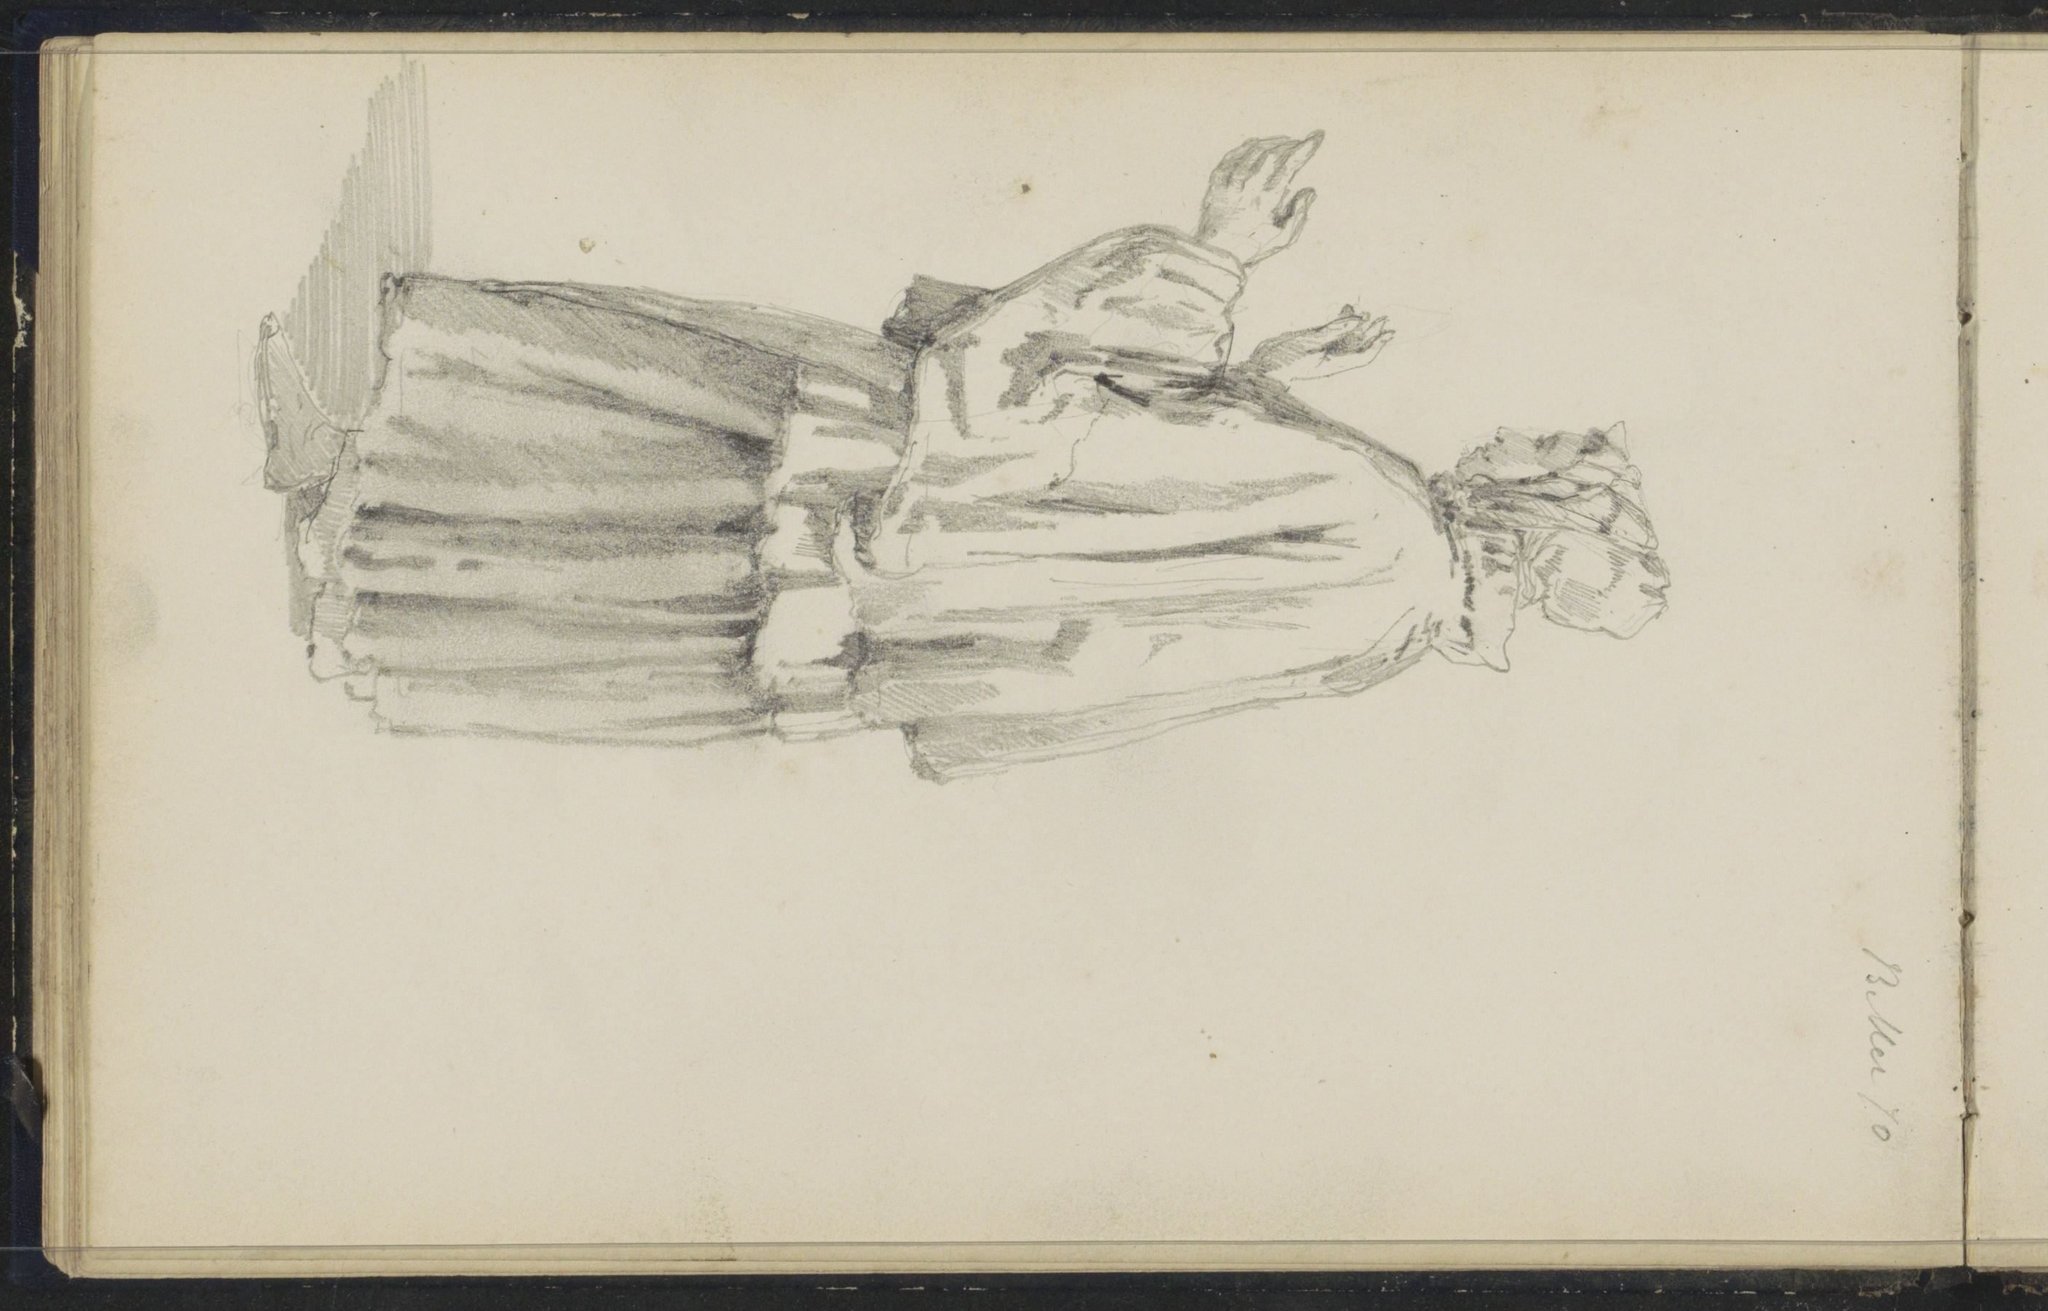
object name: sketchbook leaf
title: Vrouw met uitgestoken handen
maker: cornelis springer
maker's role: draughtsman, painter, print maker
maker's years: 1817-1891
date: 1870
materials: paper, pencil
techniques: stumping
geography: netherlands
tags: adult woman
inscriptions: date: ‘13 Mei 70’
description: Vrouw met uitgestoken handen. Blad 11 verso uit een schetsboek met 40 bladen, vervaardigd in Woerden en Gouda.